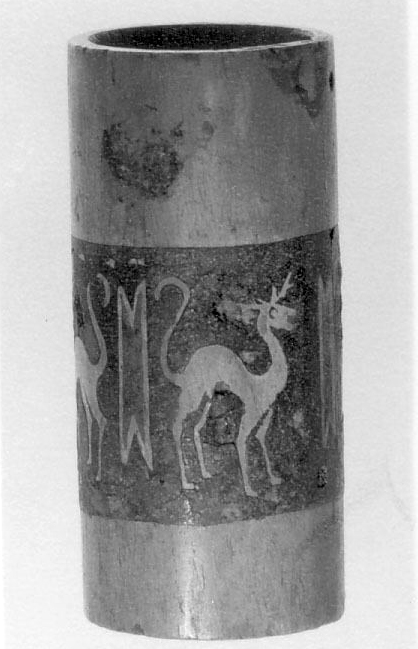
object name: ring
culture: chinese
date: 300-101 BCE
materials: bone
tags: deer